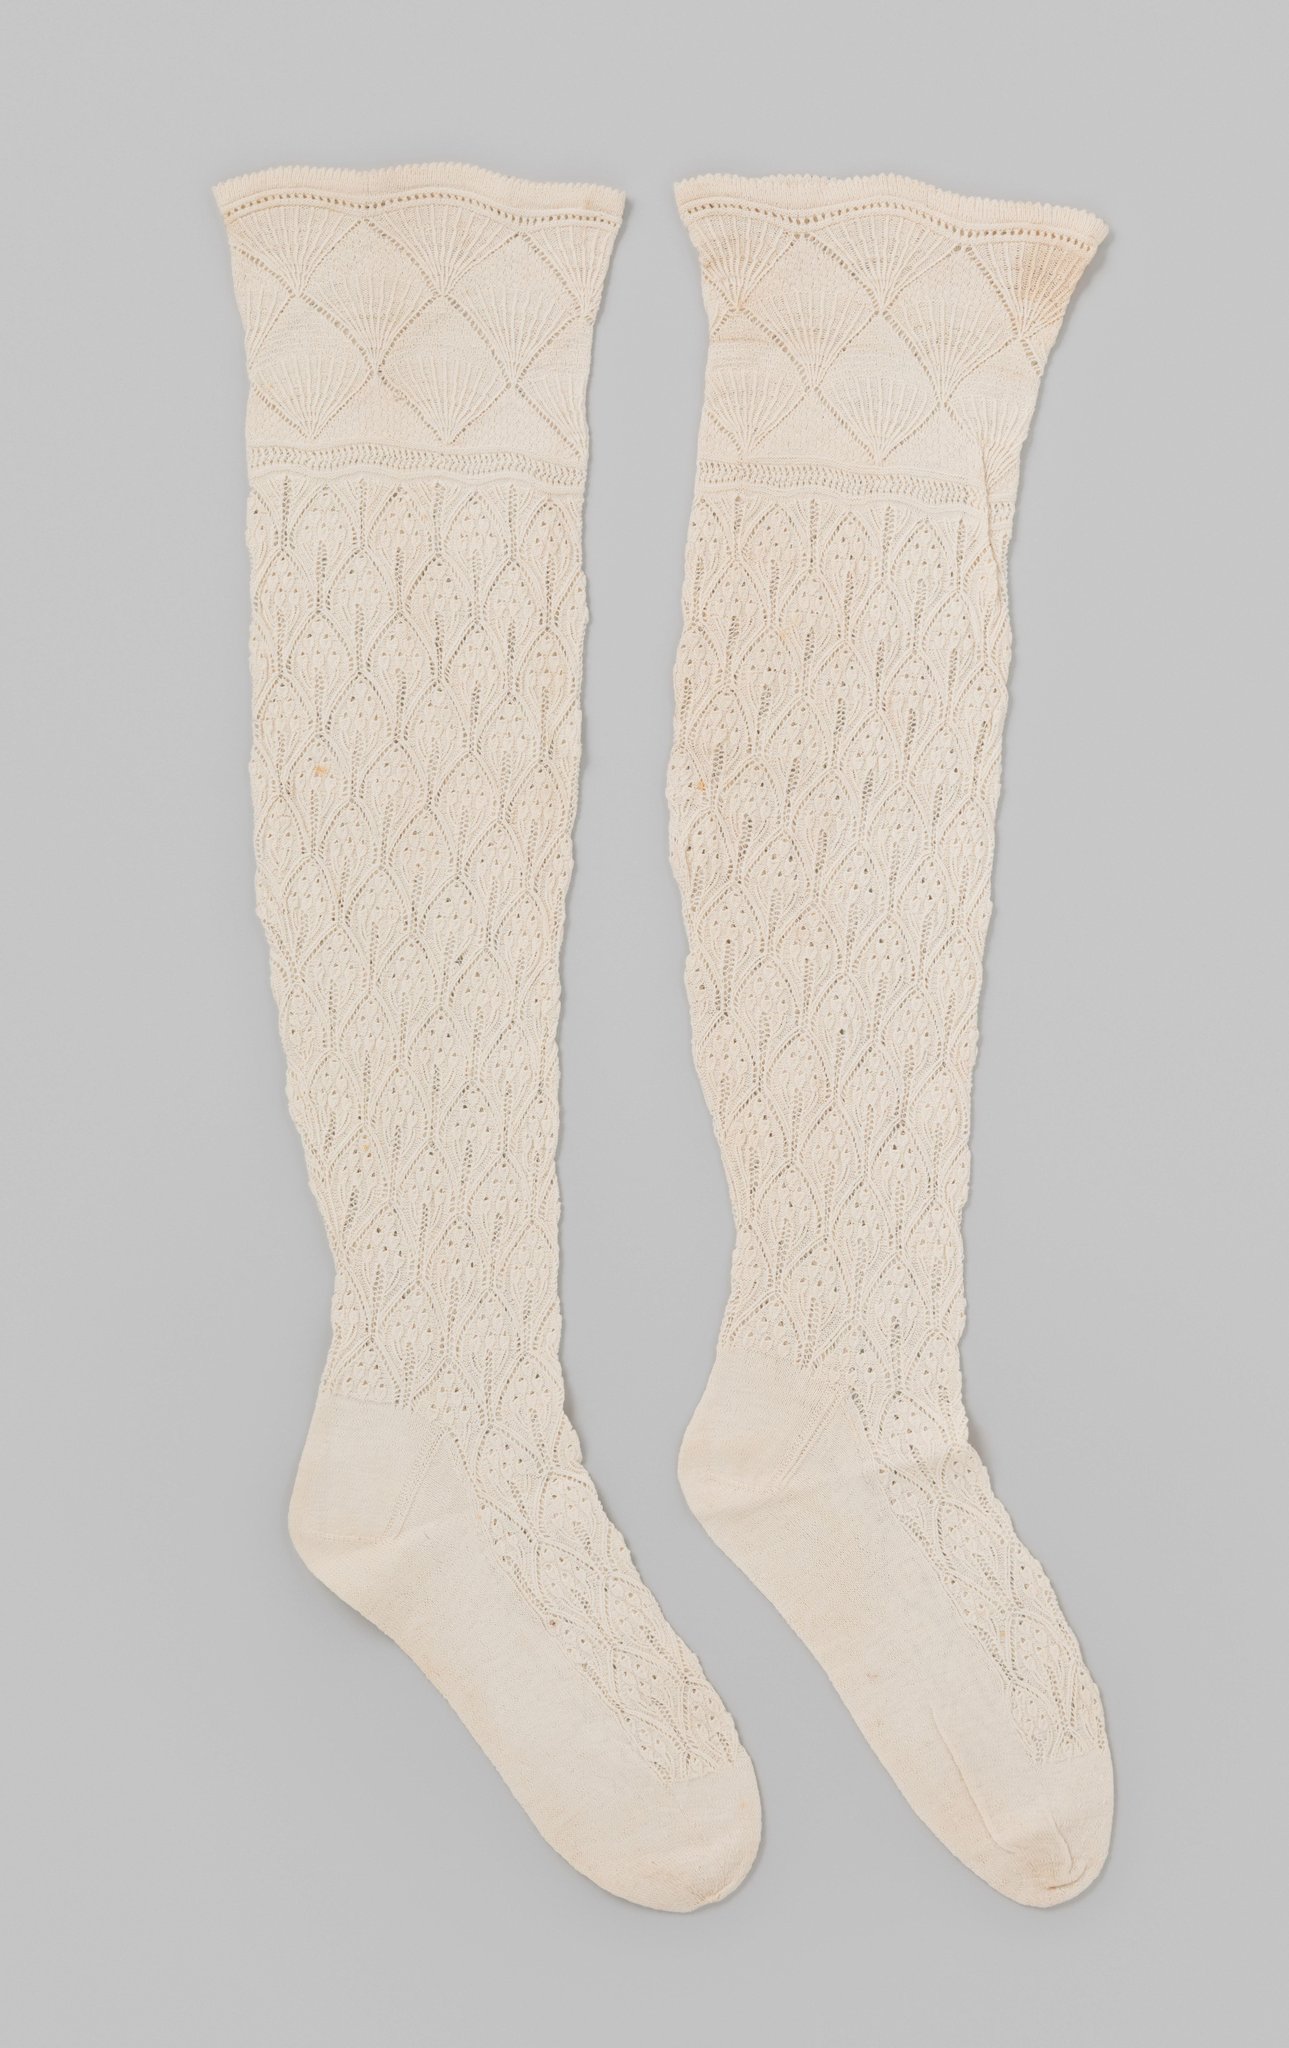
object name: womenswear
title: Kous van ajour gebreid wit katoen in een patroon van pauwenveren, met een boord in een patroon van waaiermotieven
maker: Anonymous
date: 1912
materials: cotton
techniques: embroidery, knitting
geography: netherlands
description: Kous van ajour gebreid wit katoen in een patroon van pauwenveren, met een boord in een patroon van waaiermotieven.